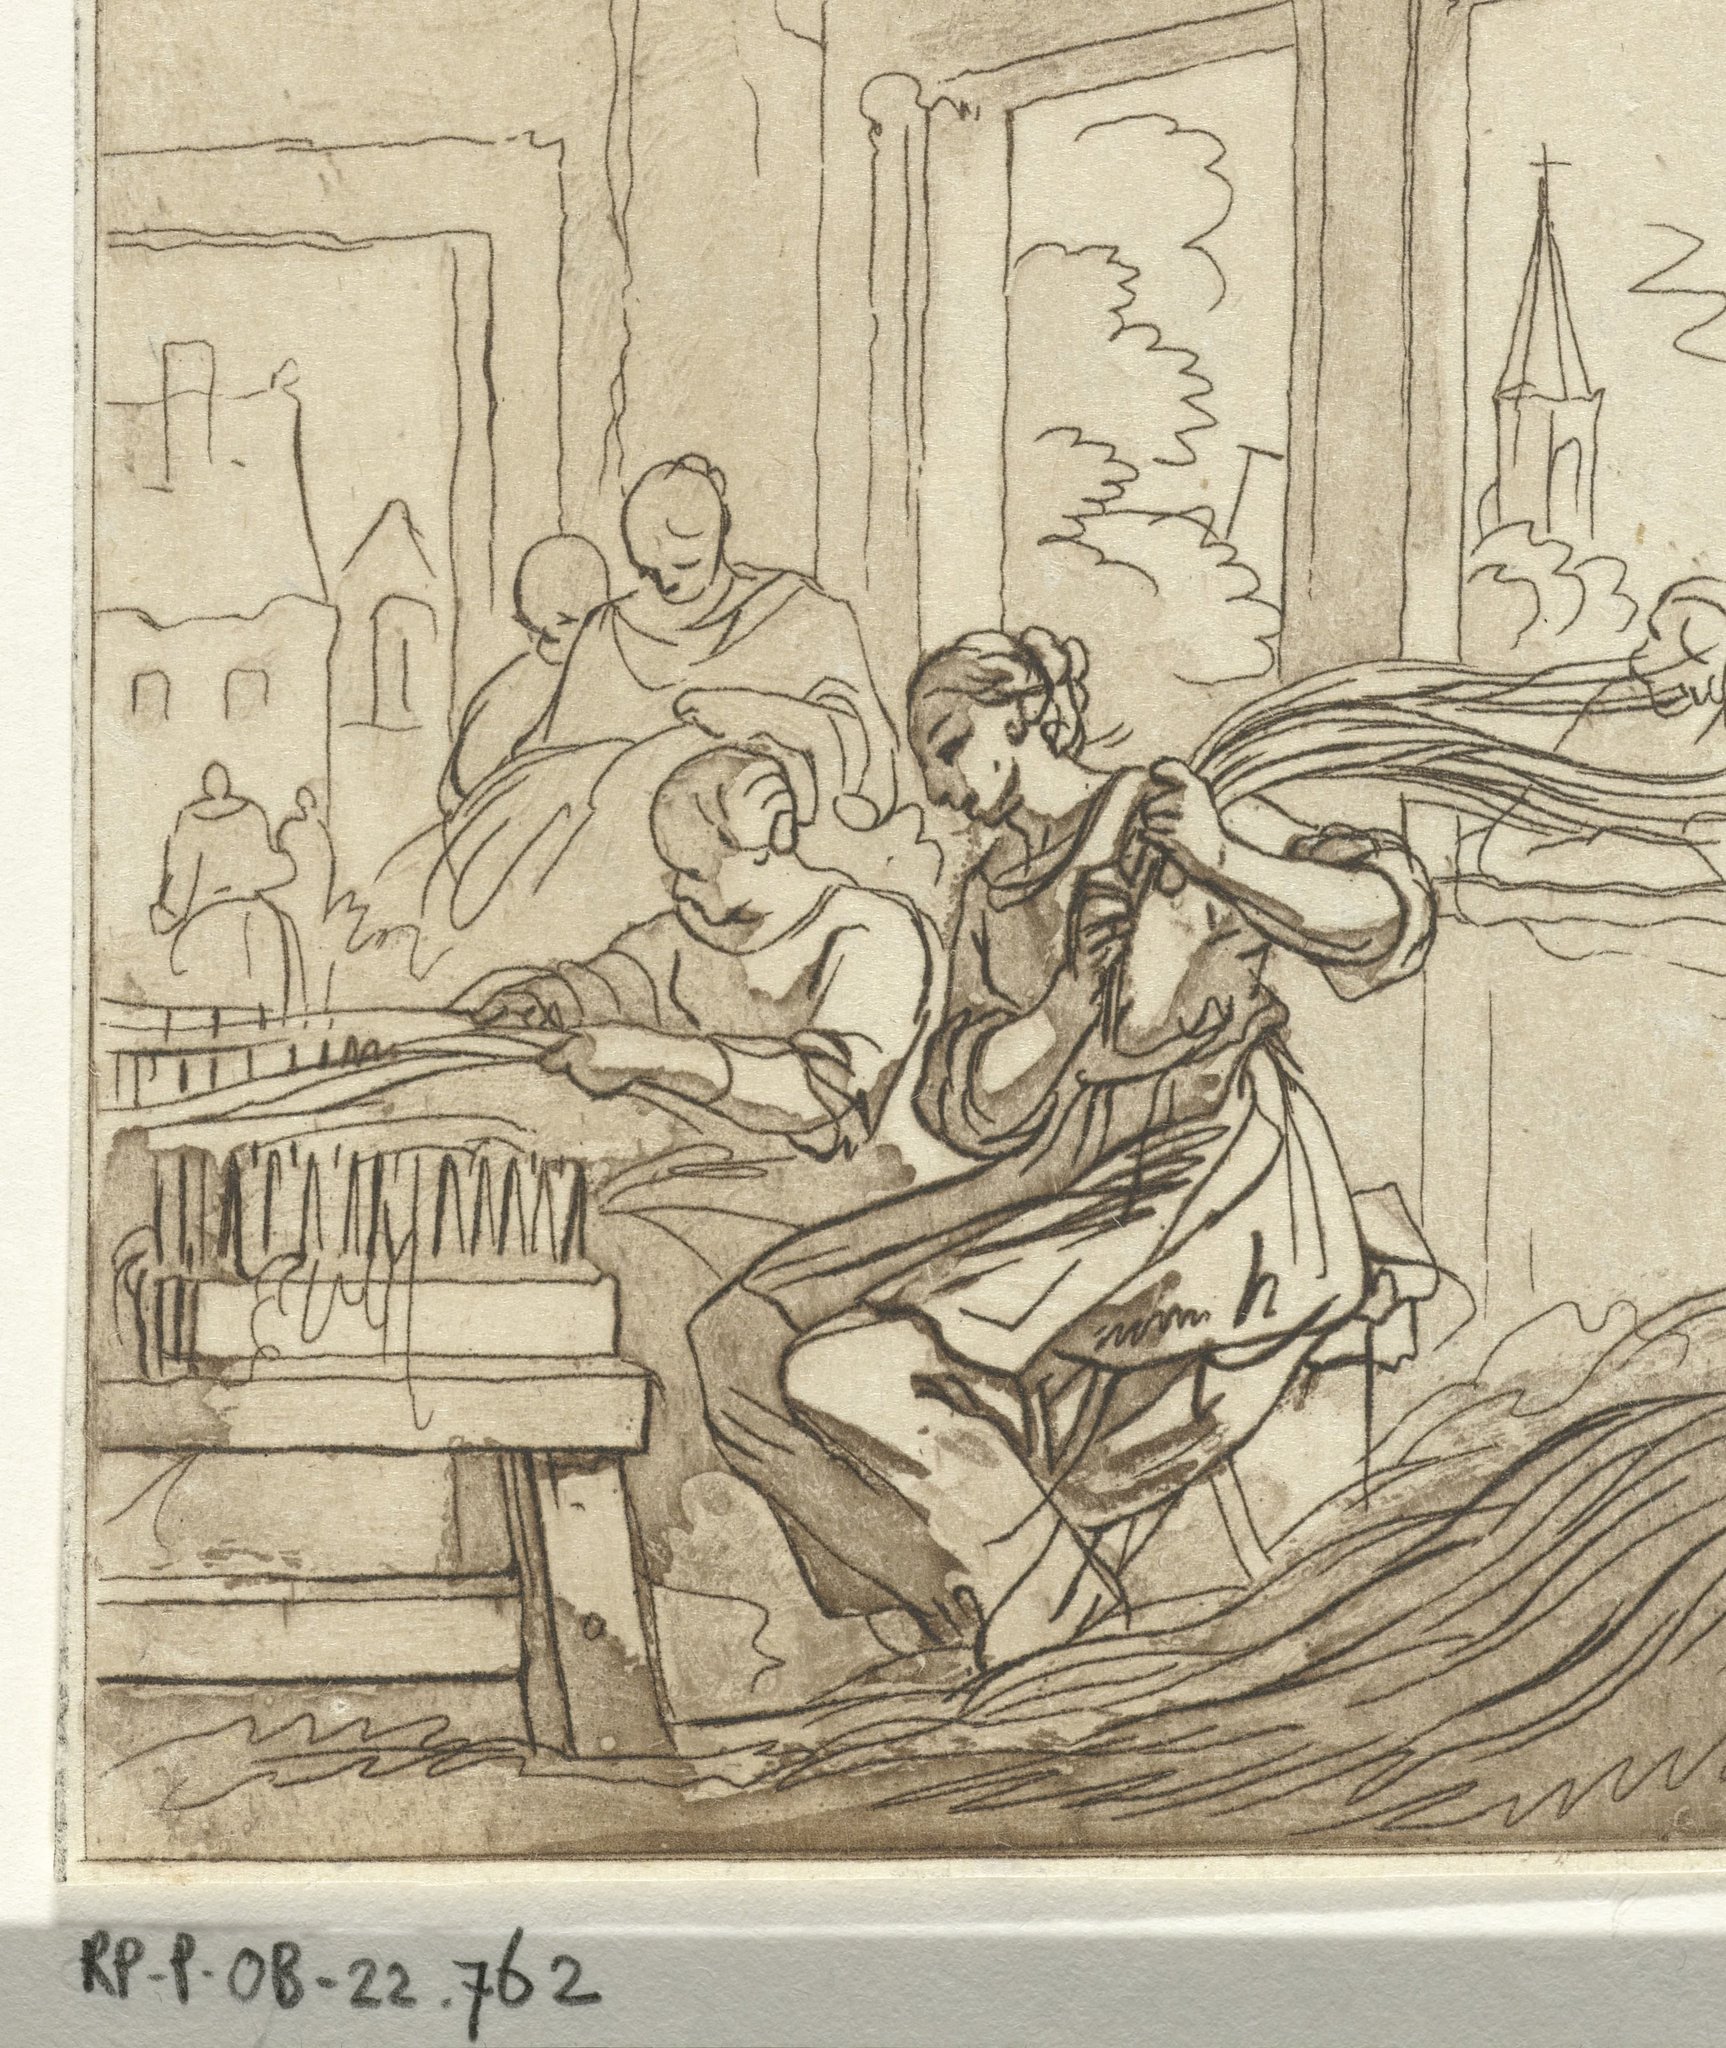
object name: print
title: Hekelende vrouwen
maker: jacob ernst marcus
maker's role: draughtsman, print maker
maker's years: 1774-1826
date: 1784-1826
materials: paper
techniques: aquatint, etching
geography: amsterdam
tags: flax (material ~ textile industry)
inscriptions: collector's mark: Lugt 2228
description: In een interieur wordt gehekeld; een onderdeel van het proces van het garen spinnen waarbij lange vezels worden gekamd, waarna het verkregen linnen naar de spinnerij gaat om er garen van te maken.